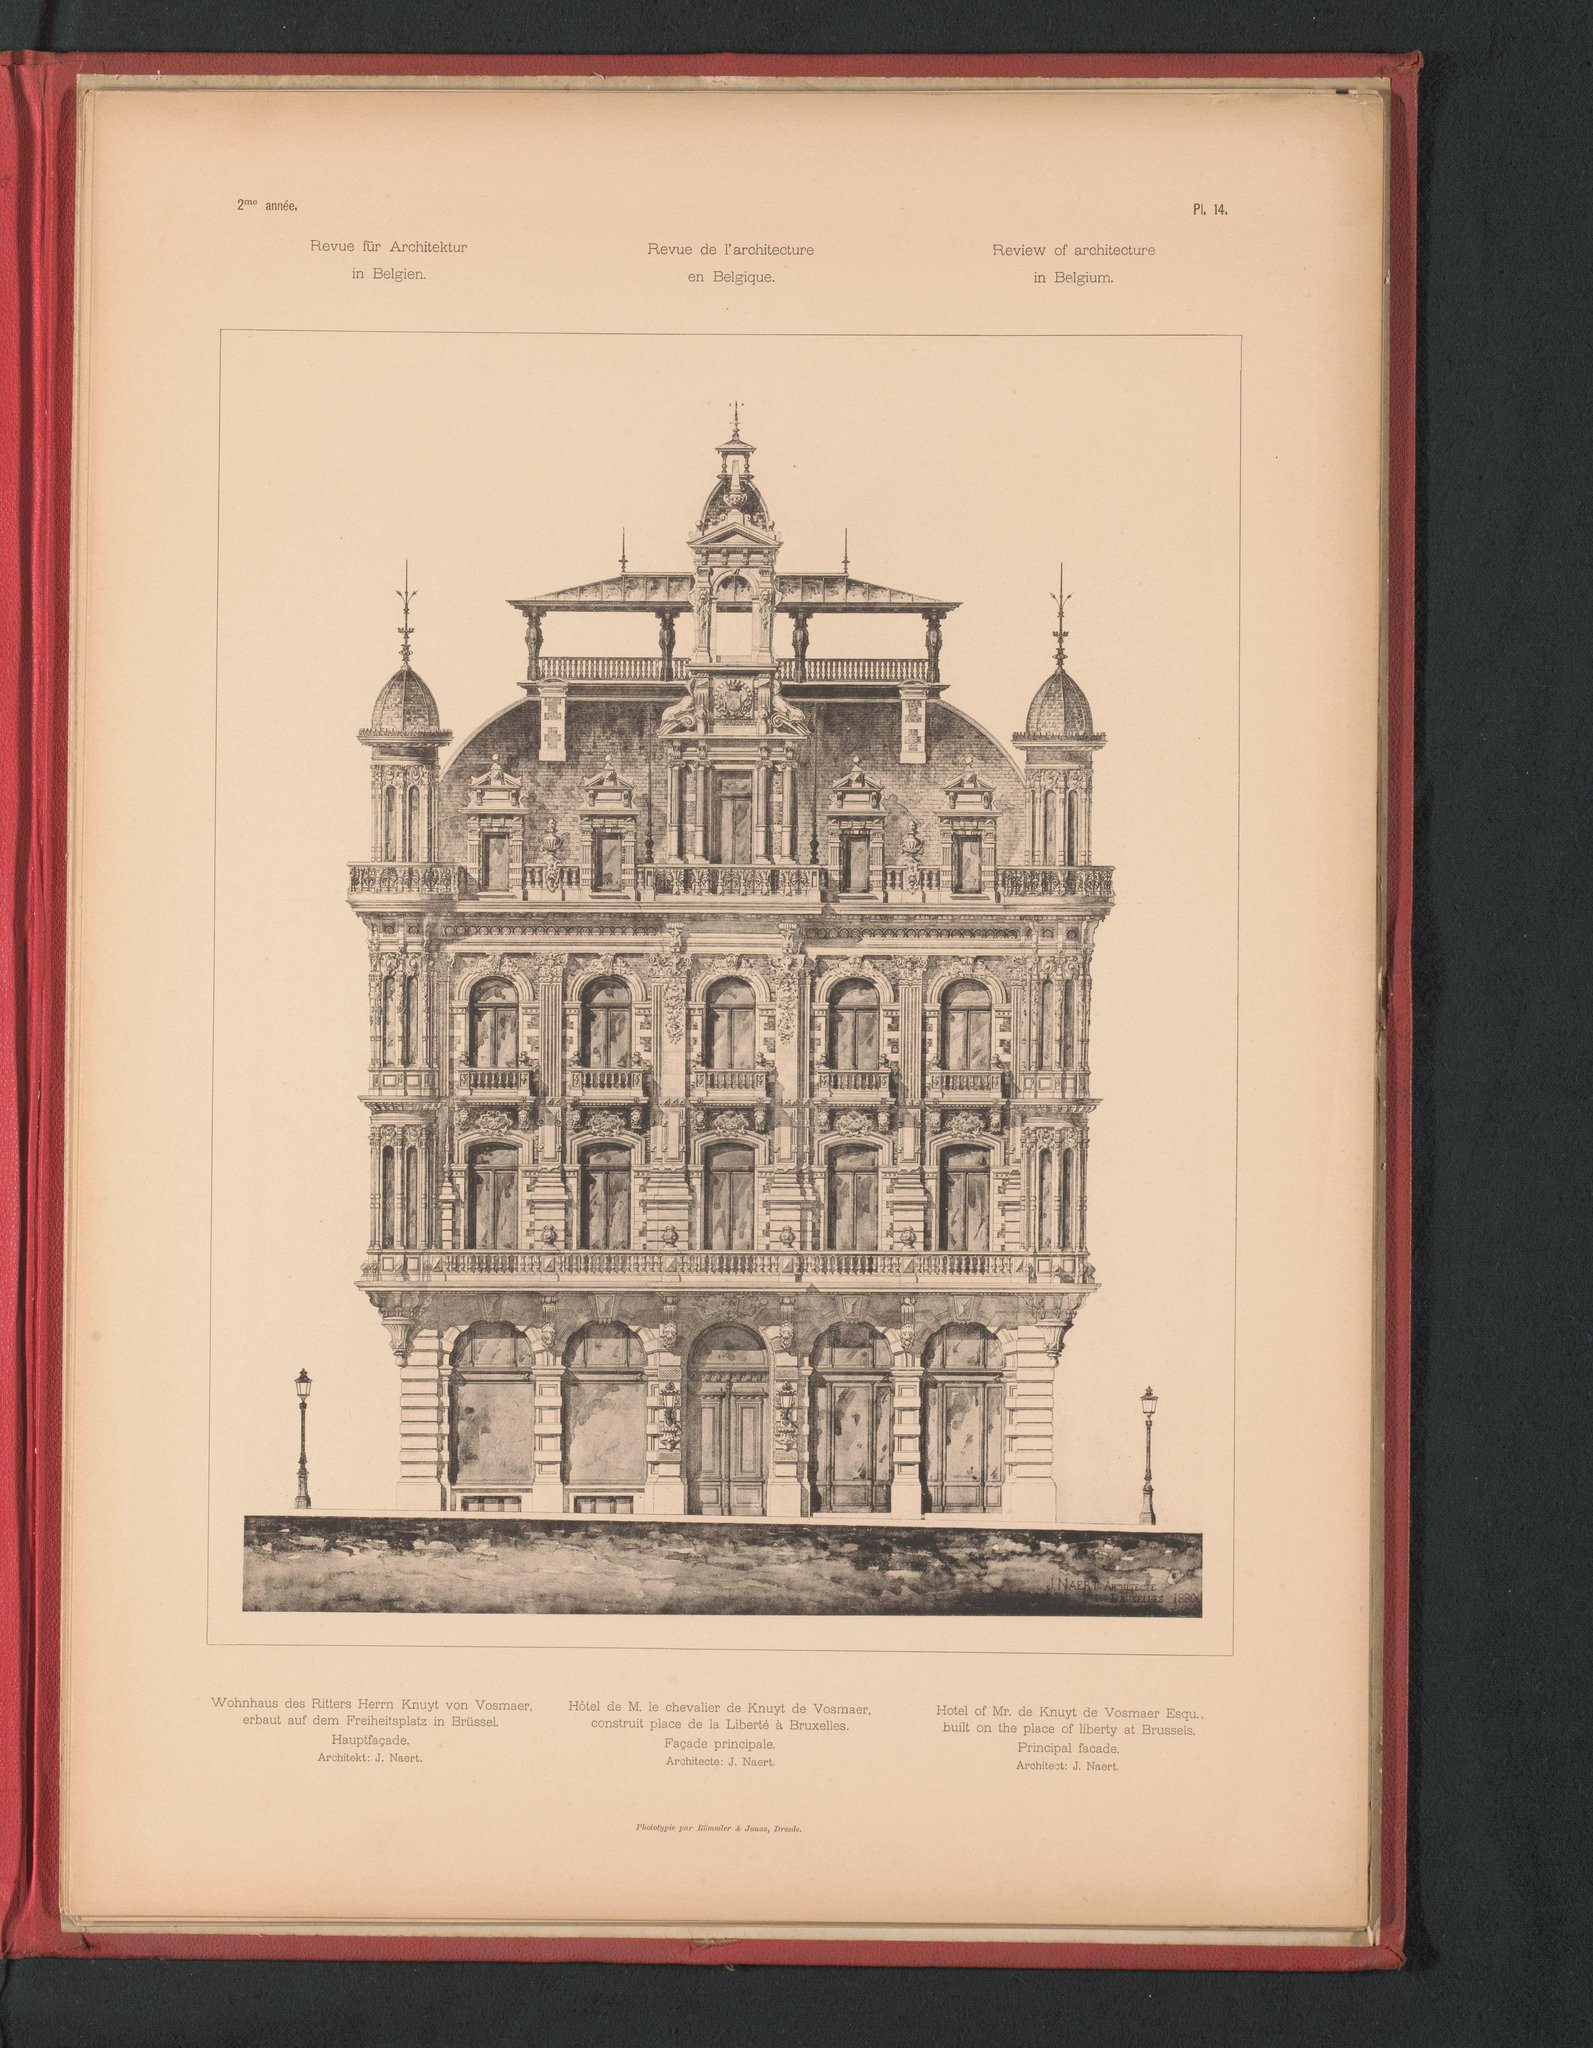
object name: reproduction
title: Hôtel de M. le chevalier de Knuyt de Vosmaer, construit place de la Liberté à Bruxelles. Façade principale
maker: joseph naert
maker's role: architect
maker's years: 1838-1910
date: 1888-1893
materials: paper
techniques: photograph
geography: dresden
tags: exterior ~ architectural design or model, civic architecture; edifices; dwellings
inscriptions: number: ‘Pl. 14.’, inscription: ‘2me. année.’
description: Deze prent maakt deel uit van een omslag met 110 prenten op 90 bladen en 18 tekstbladen.